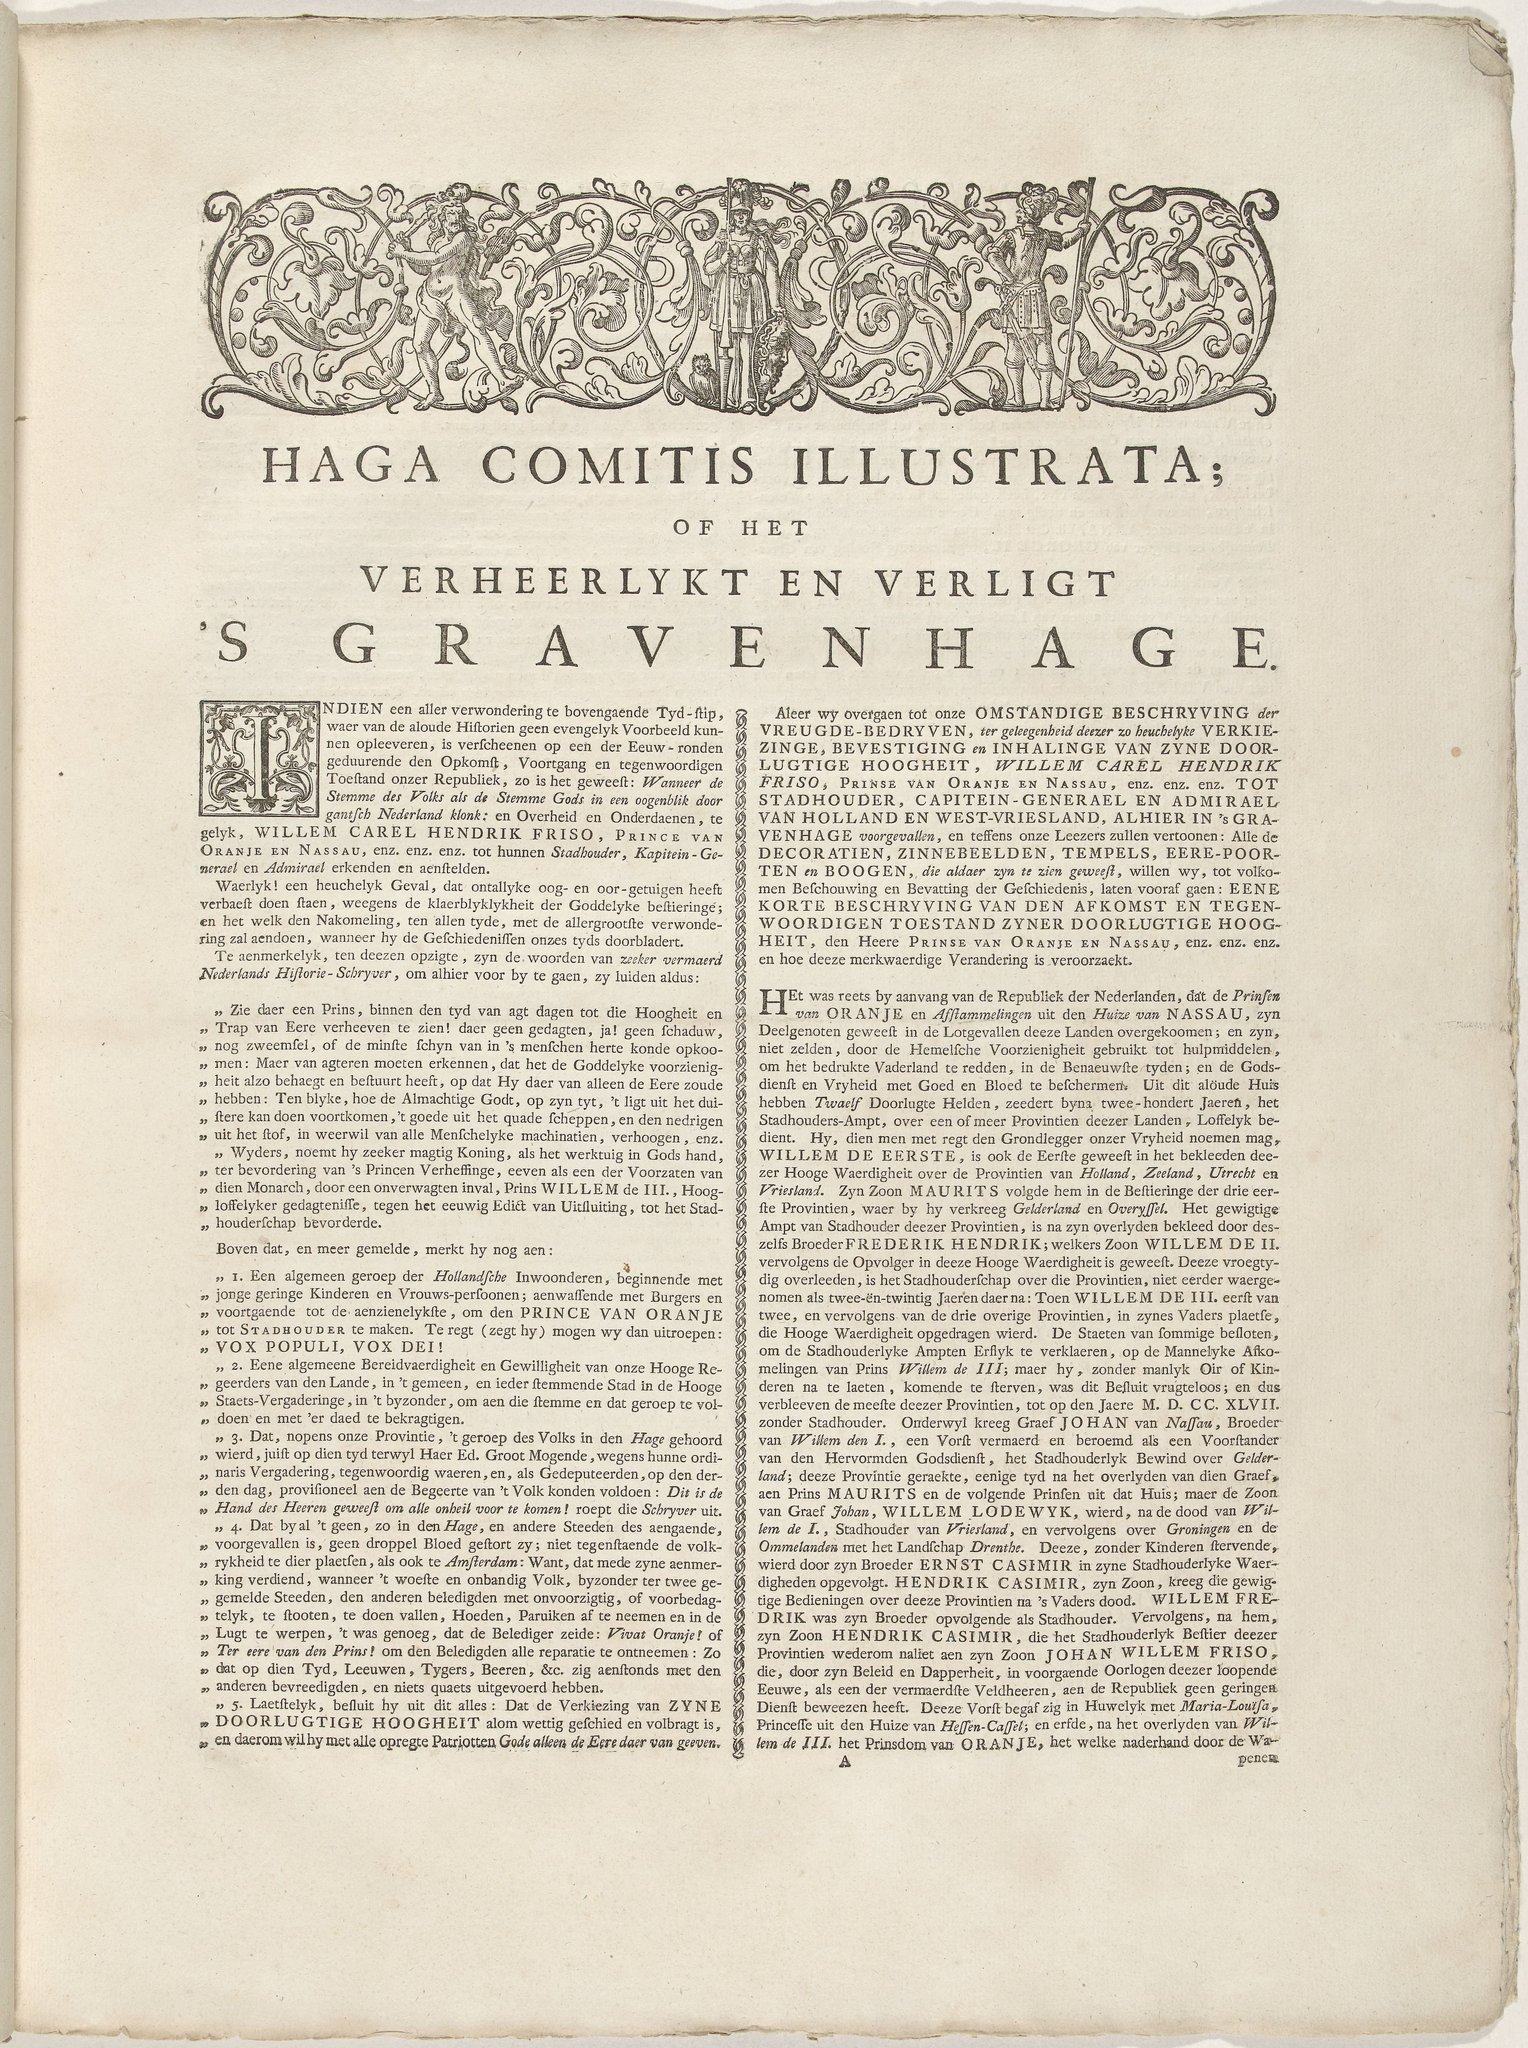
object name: print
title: Eerste blad in: Haga comitis illustrata; of het verheerlykt en verligt 's Gravenhage, 's-Gravenhage 1751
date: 1751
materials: paper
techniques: letterpress printing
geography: northern netherlands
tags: willem iv (prins van oranje-nassau), the hague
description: Eerste tekstblad met tekst in twee kolommen en bovenaan een vignet met Minerva, een wildeman en een soldaat tussen bladranken. Los blad oorspronkelijk onderdeel van het plaatwerk Haga comitis illustrata uit 1751 met de versieringen opgesteld te Den Haag tijdens de feestelijkheden rond de installatie van prins Willem IV als stadhouder van Holland en West-Friesland op 3 en 15 mei 1747.